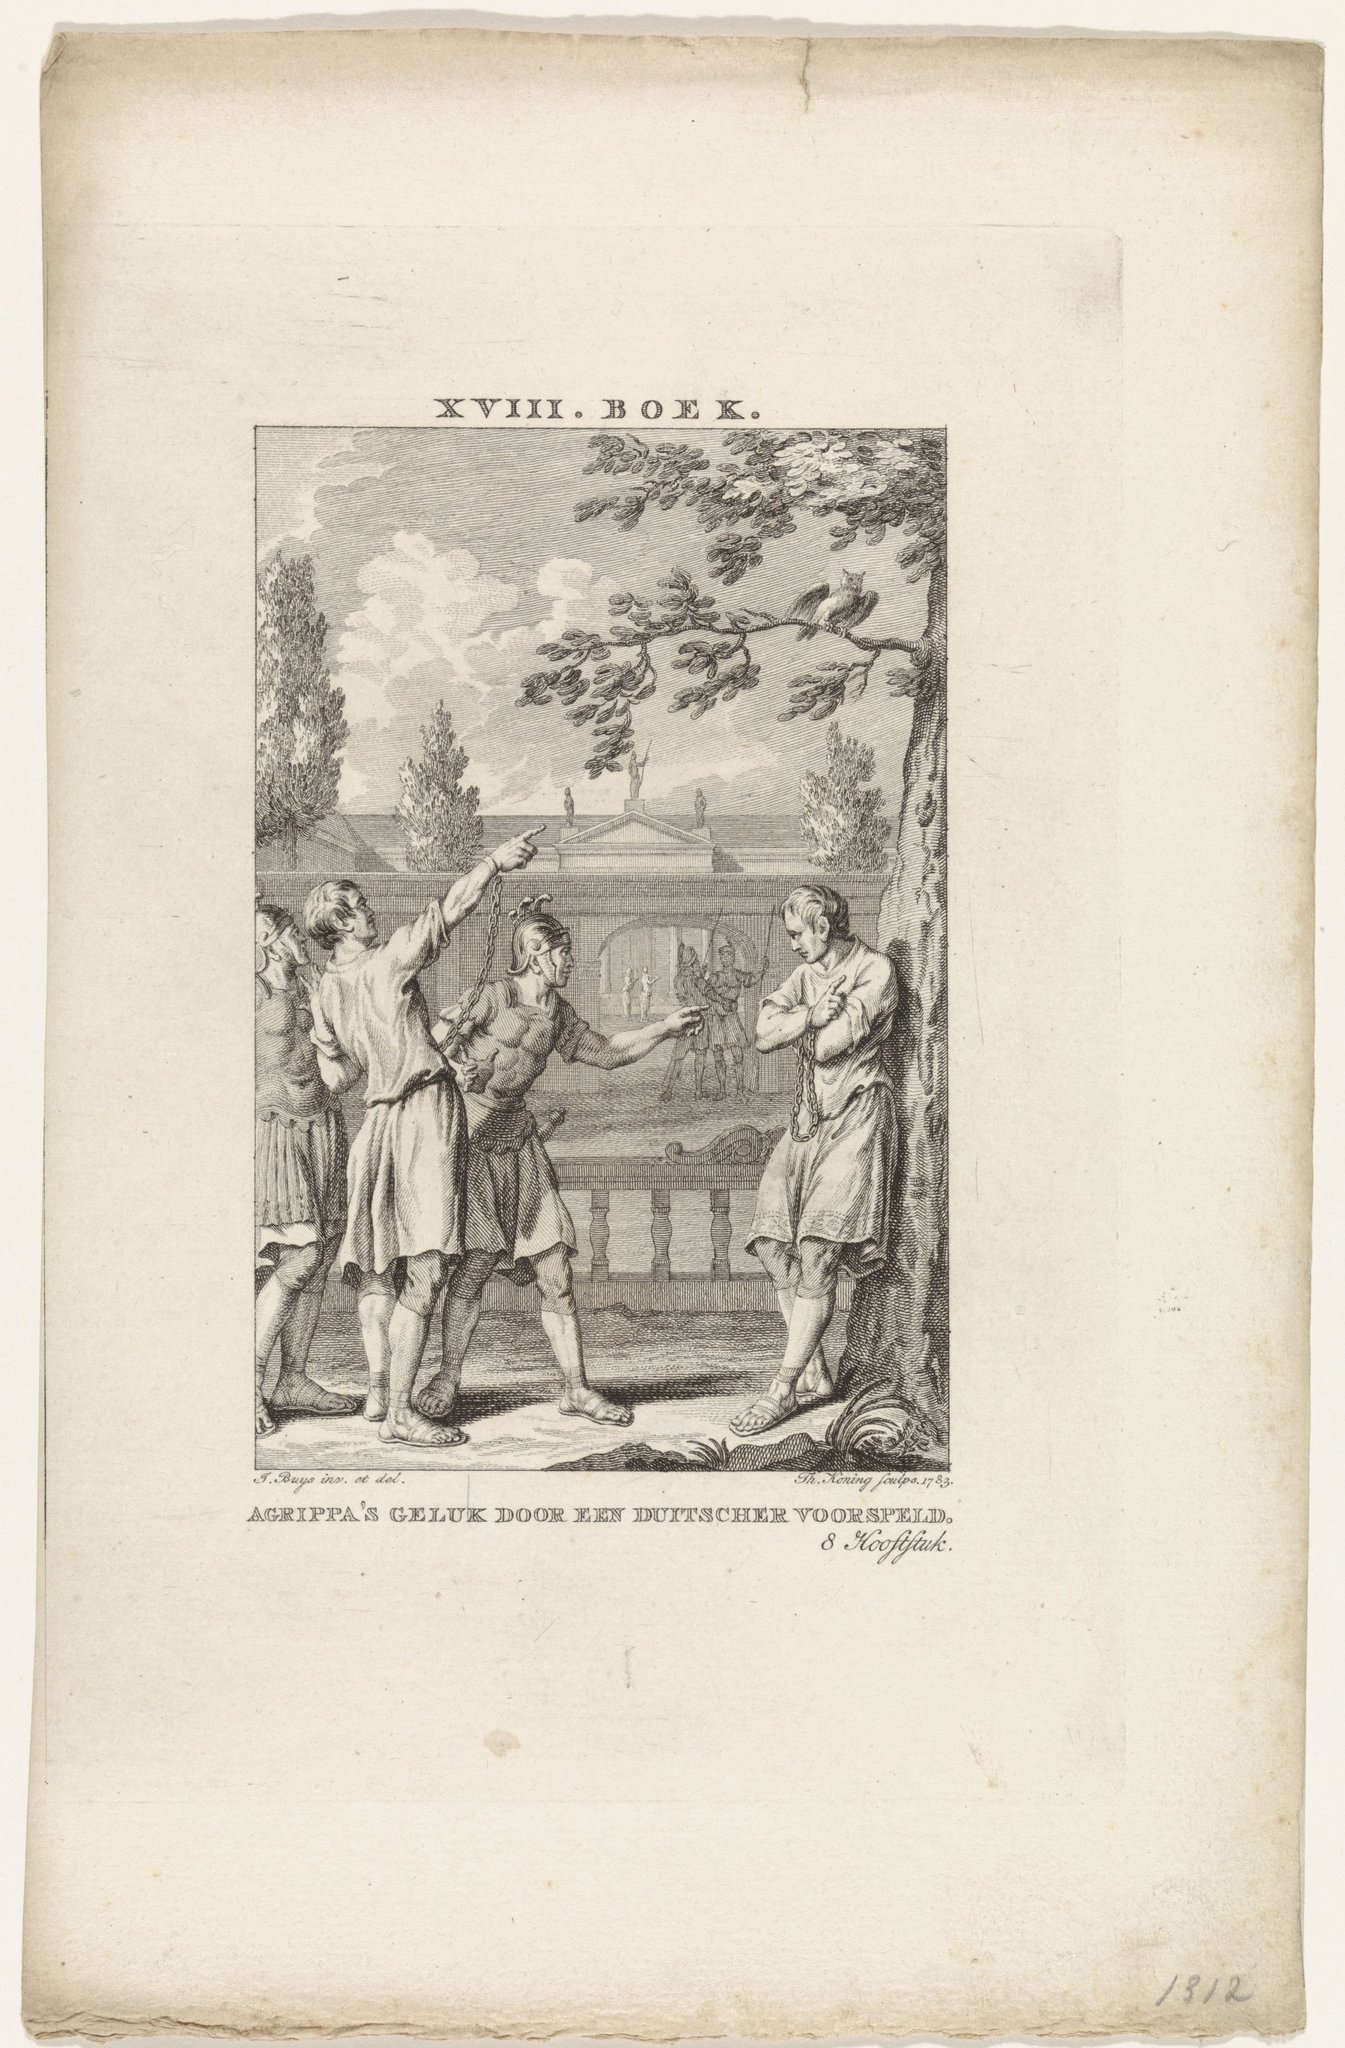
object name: book illustration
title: Voorspelling van Agrippa's geluk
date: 1783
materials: paper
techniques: engraving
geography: amsterdam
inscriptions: collector's mark: Lugt 2228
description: De geboeide Agrippa (de kleinzoon van Herodes de Grote) leunt peinzend tegen een boom waarop een uil zit. Een Duitse medegevangene wijst naar de uil, en vertelt dat Agrippa spoedig zijn vrijheid terug zal krijgen en een gelukkig leven tegemoet zal gaan. Tevens zegt de Duitser dat Agrippa nog maar vijf dagen te leven heeft wanneer de uil nogmaals verschijnt. Deze prent is een illustratie bij het achtste hoofdstuk van het achttiende boek van 'Alle de werken van Flavius Josephus'.